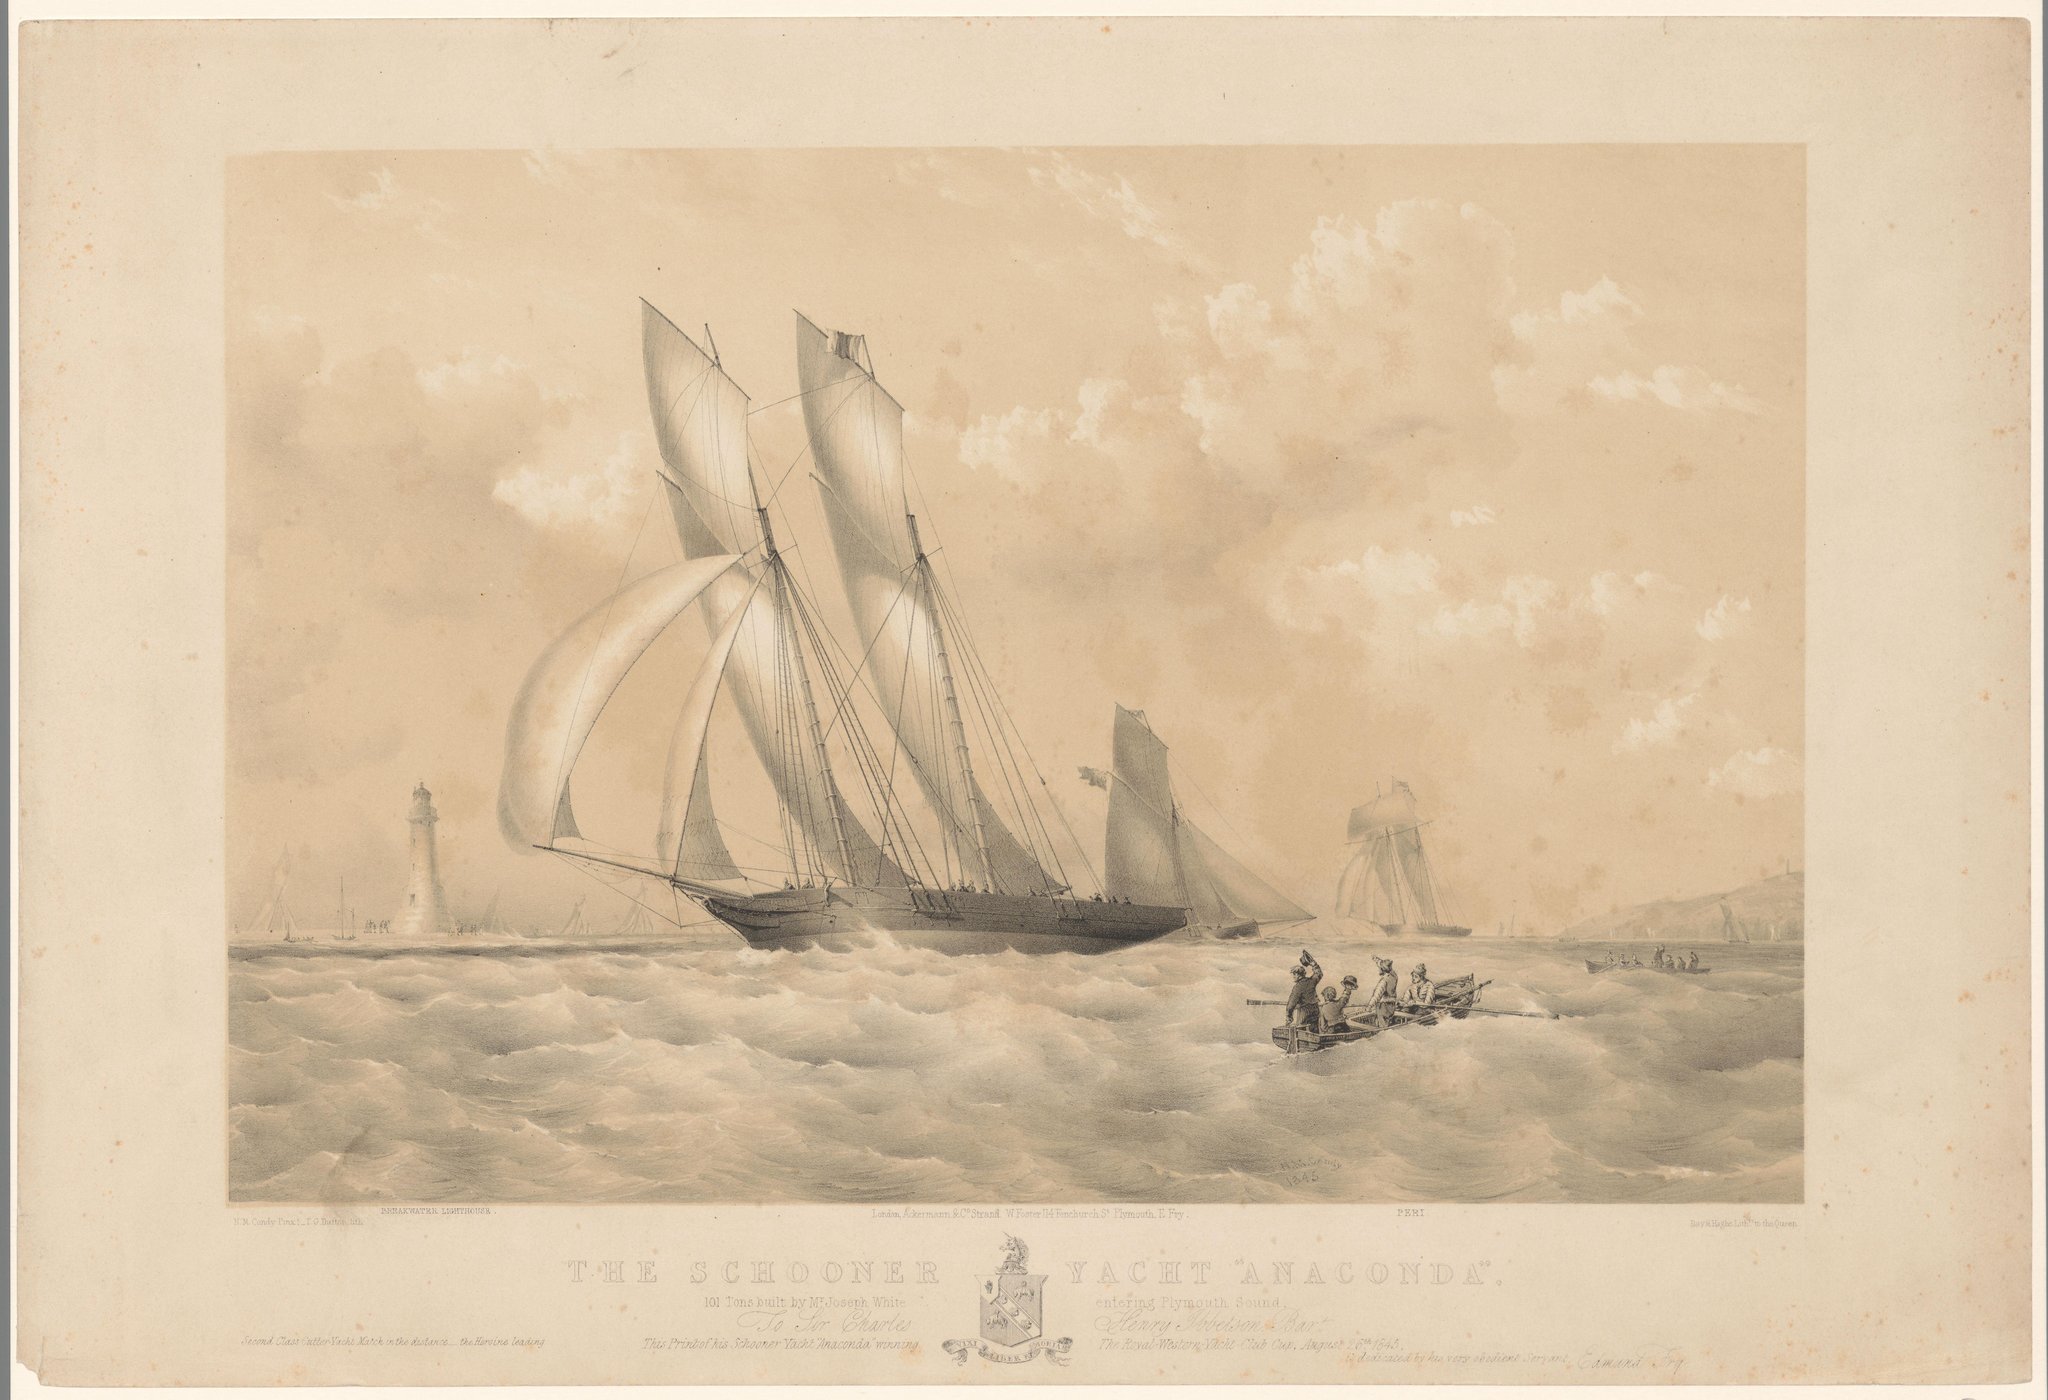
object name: print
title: Zeilschip de Anaconda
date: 1845-1850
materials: paper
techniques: tone lithography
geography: plymouth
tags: sailing-ship, sailing-boat, landscapes with waters, waterscapes, seascapes (in the temperate zone), rowing-boat, canoe, etc.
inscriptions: collector's mark: Lugt 2228